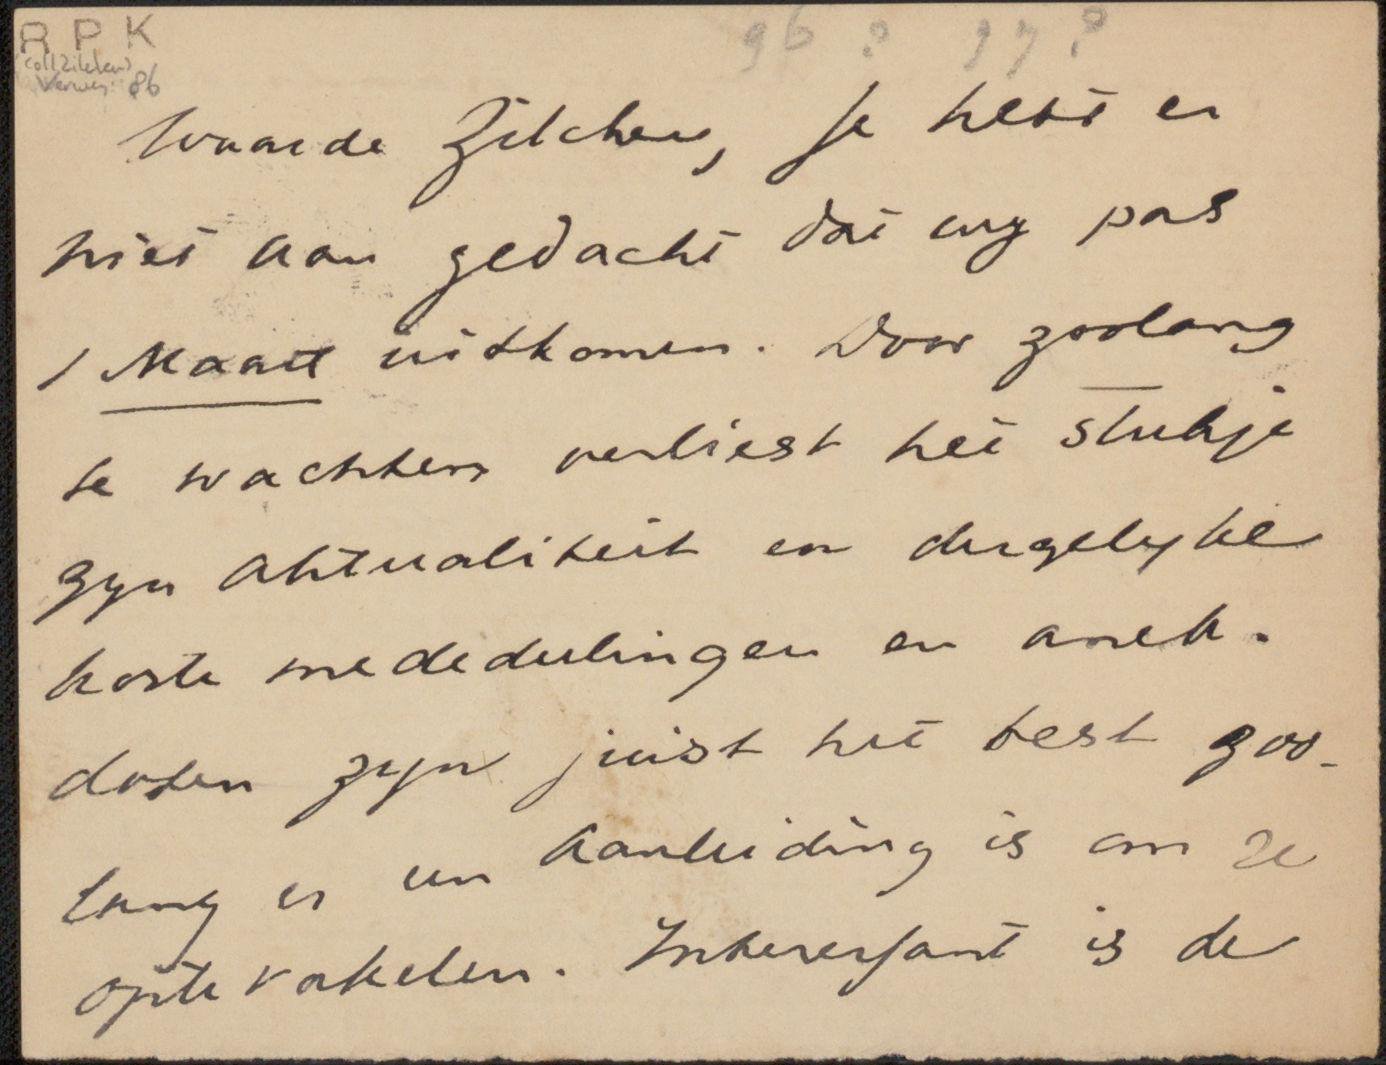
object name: letter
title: Brief aan Philip Zilcken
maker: albert verwey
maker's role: criticus, dichter, essayist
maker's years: 1865-1937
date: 1875-1930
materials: ink, paper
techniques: pen, writing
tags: the hague, painter, draughtsman, philip zilcken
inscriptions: collector's mark: ‘RPK’